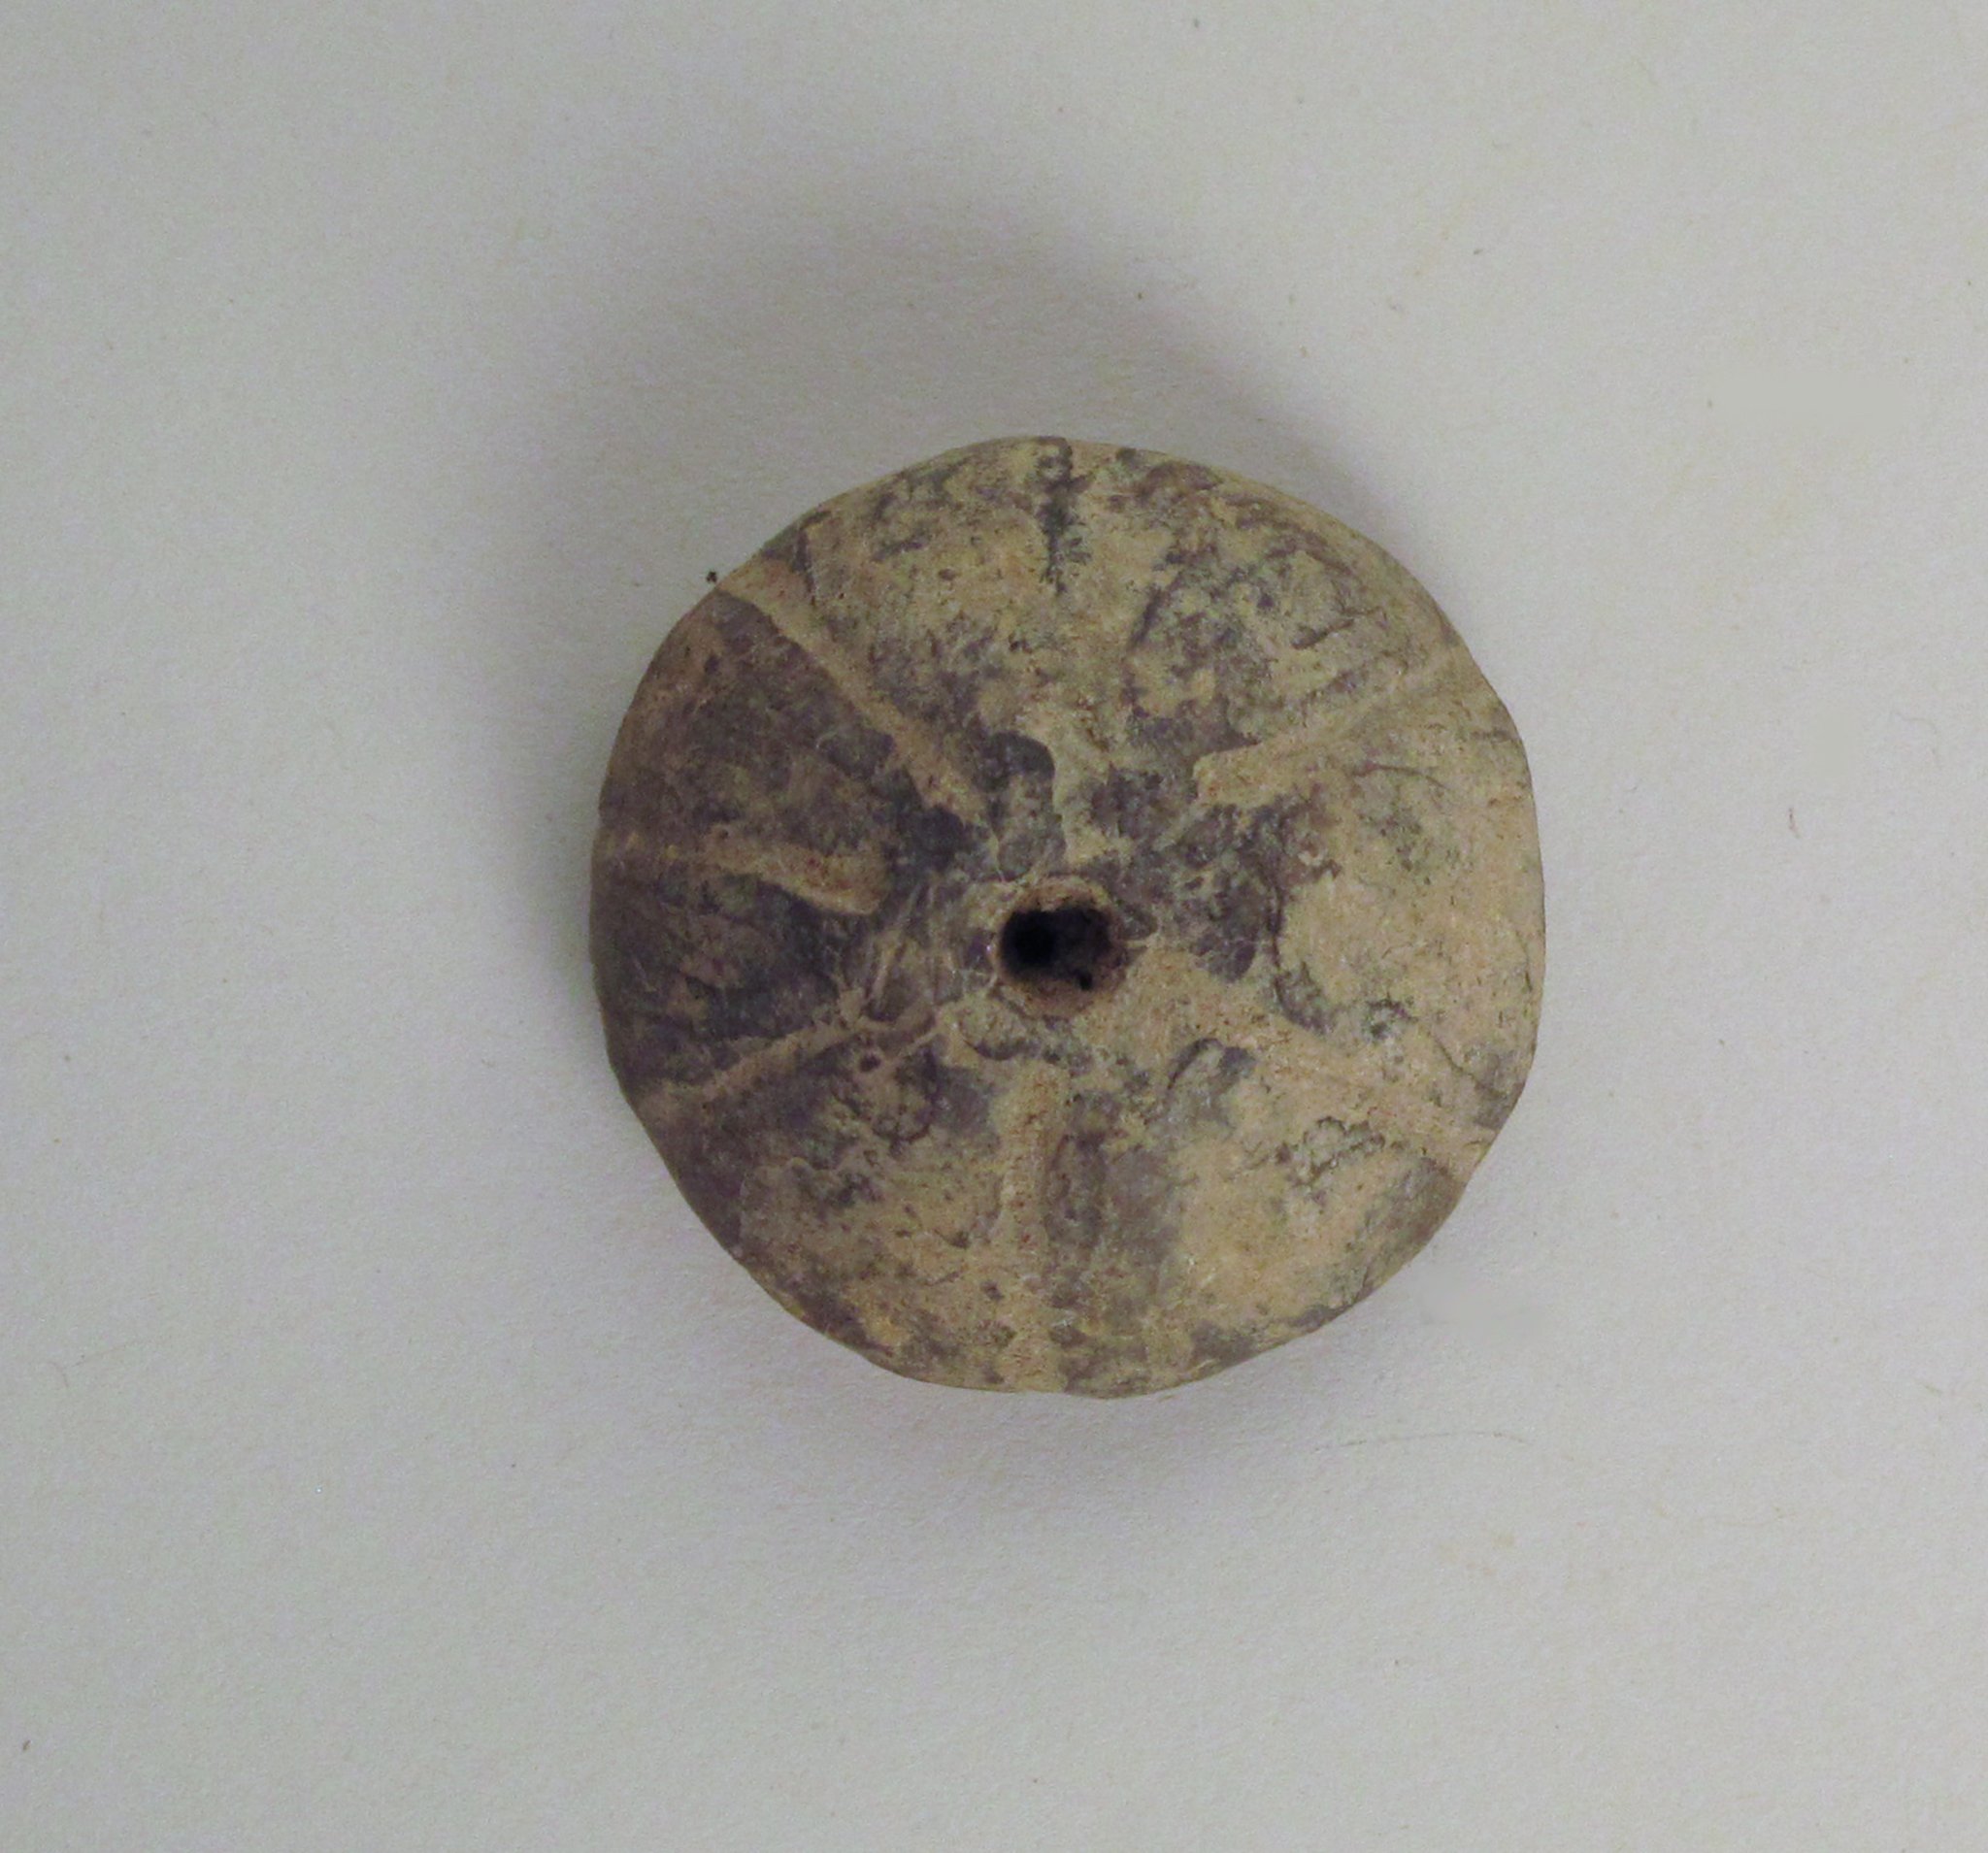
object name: roundel, disk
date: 7000 BCE-330 CE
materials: clay